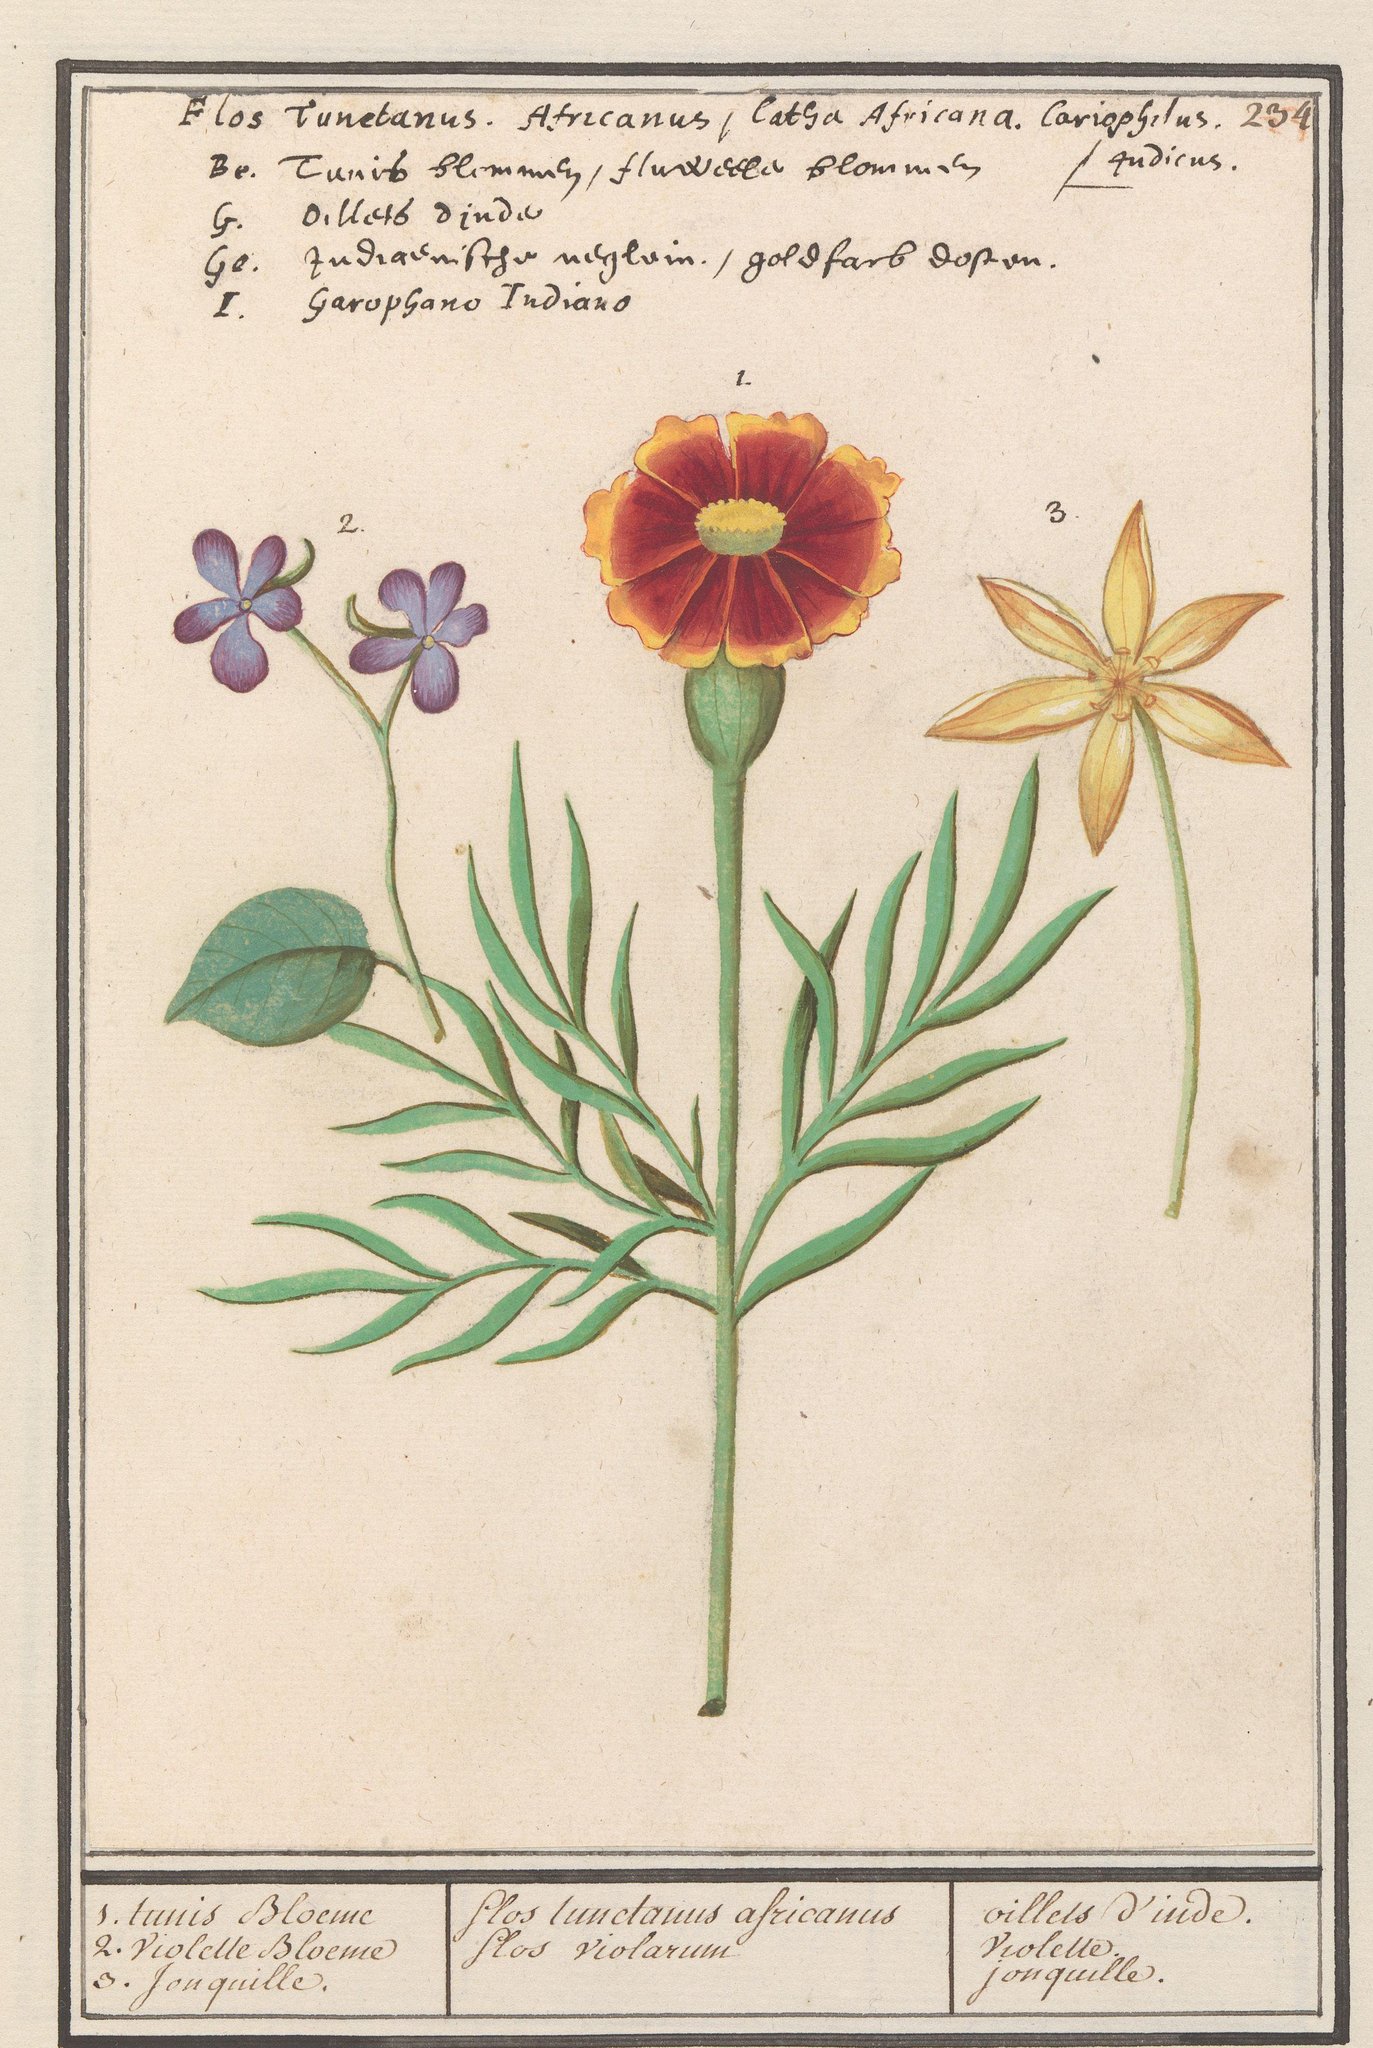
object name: drawing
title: 1. tunis Bloeme 2. Violette Bloeme 3. Jonquille. / flos tunctanus africanus flos violarum / oillets d'inde. violette. jonquille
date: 1596-1610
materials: chalk, paint, ink, paper, watercolor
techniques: brush, pen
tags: flowers: violet, flowers: marigold, flowers: star-of-bethlehem, flowers: narcissus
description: Een afrikaantje, twee paarse viooltjes en een narcis of vogelmelk. Genummerd rechtsboven: 234. Bovenaan de naam in vijf talen. Onderdeel van het derde album met tekeningen van bloemen en planten. Tiende van twaalf albums met tekeningen van dieren, vogels en planten bekend rond 1600, gemaakt in opdracht van keizer Rudolf II. Met toelichting in Nederlands, Latijn en Frans.